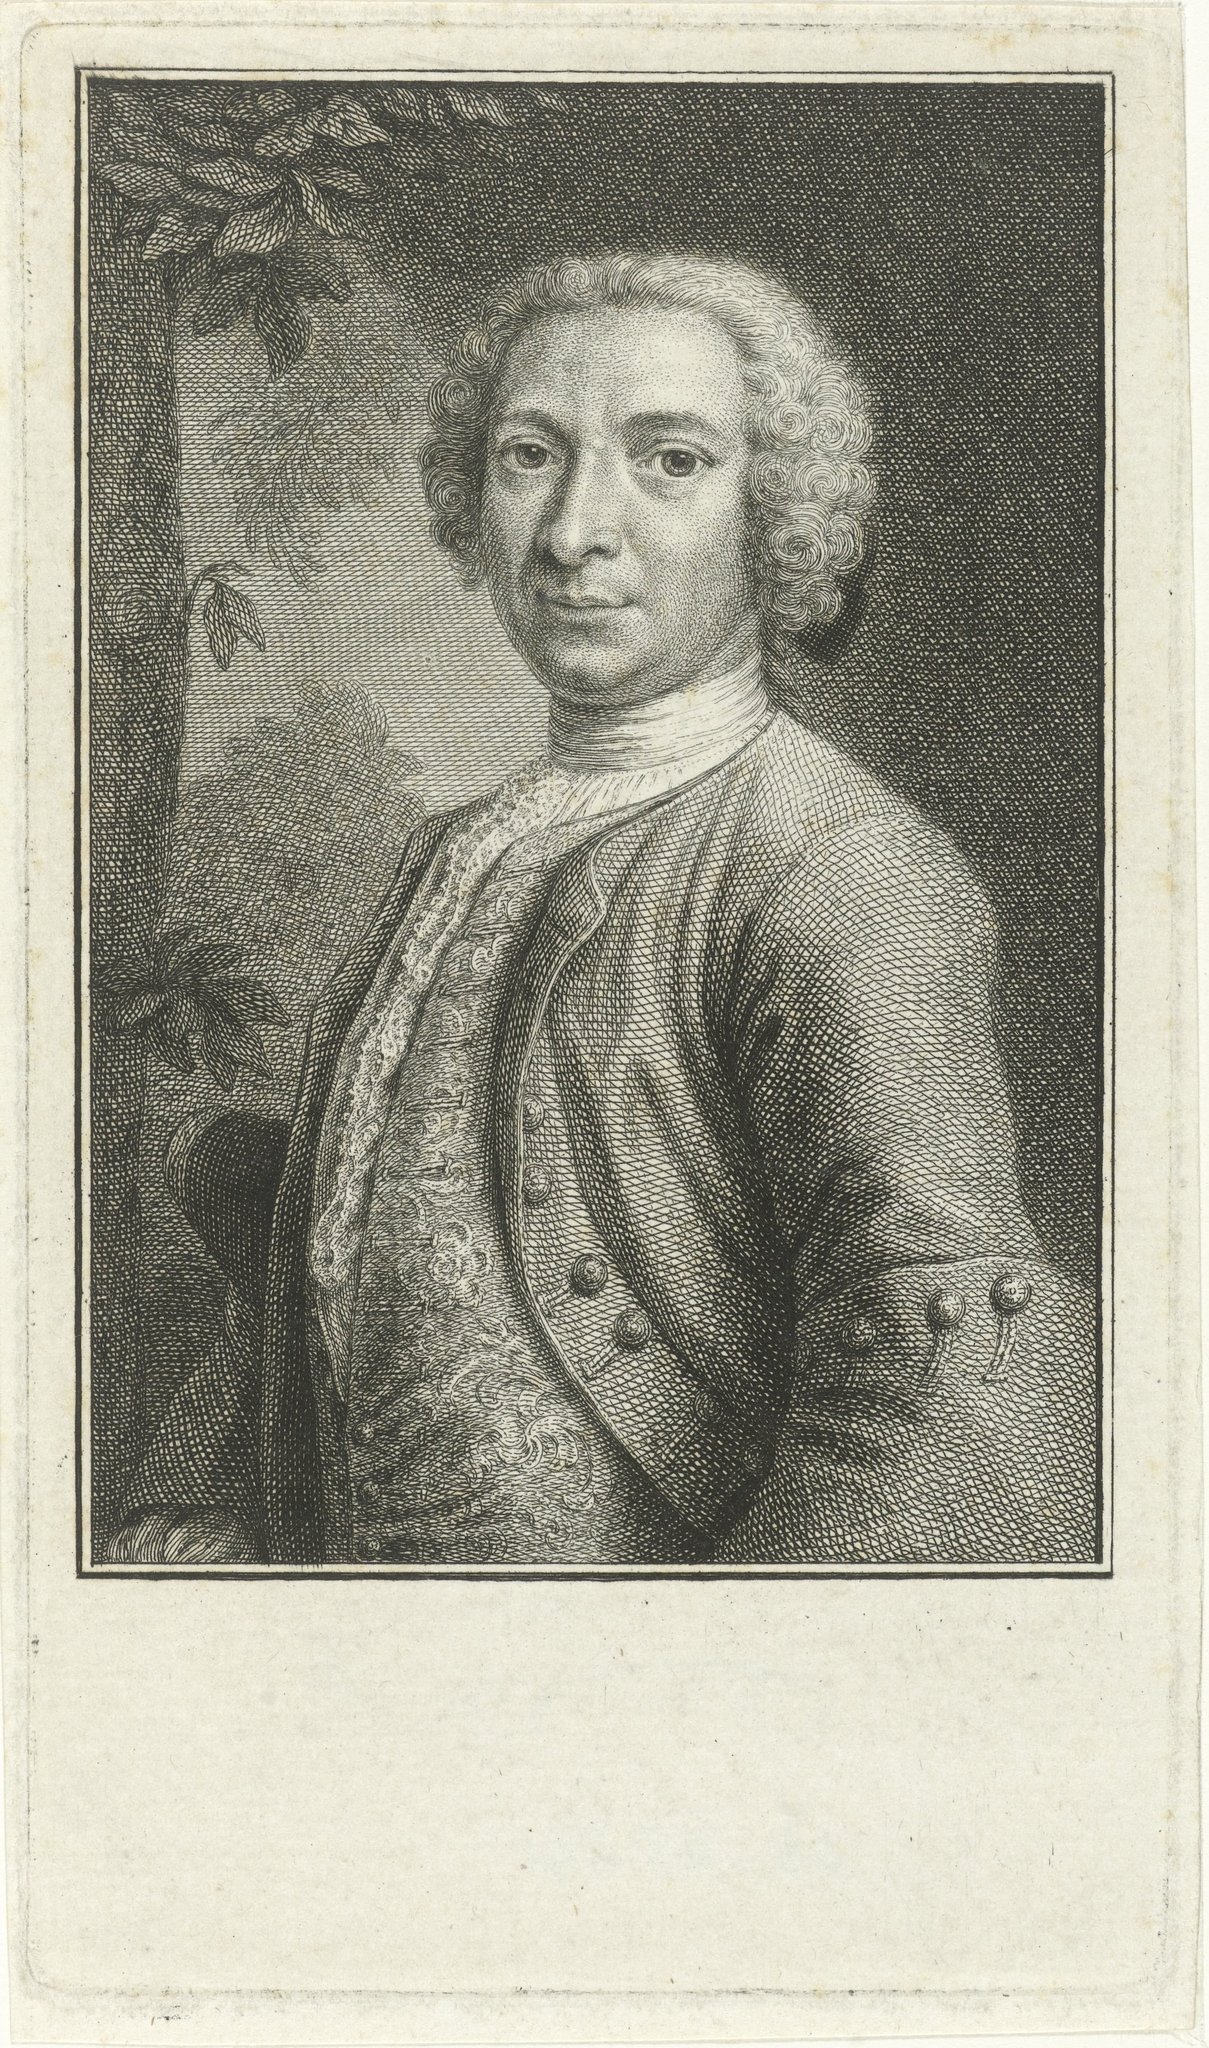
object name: print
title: Portret van Justus van Effen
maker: pieter tanjé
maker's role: draughtsman, print maker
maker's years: 1706-1761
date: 1716-1761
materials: paper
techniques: engraving, etching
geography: amsterdam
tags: den bosch, trees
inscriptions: collector's mark: Lugt 2228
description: Portret van schrijver en dichter Justus van Effen staande naast een boom.